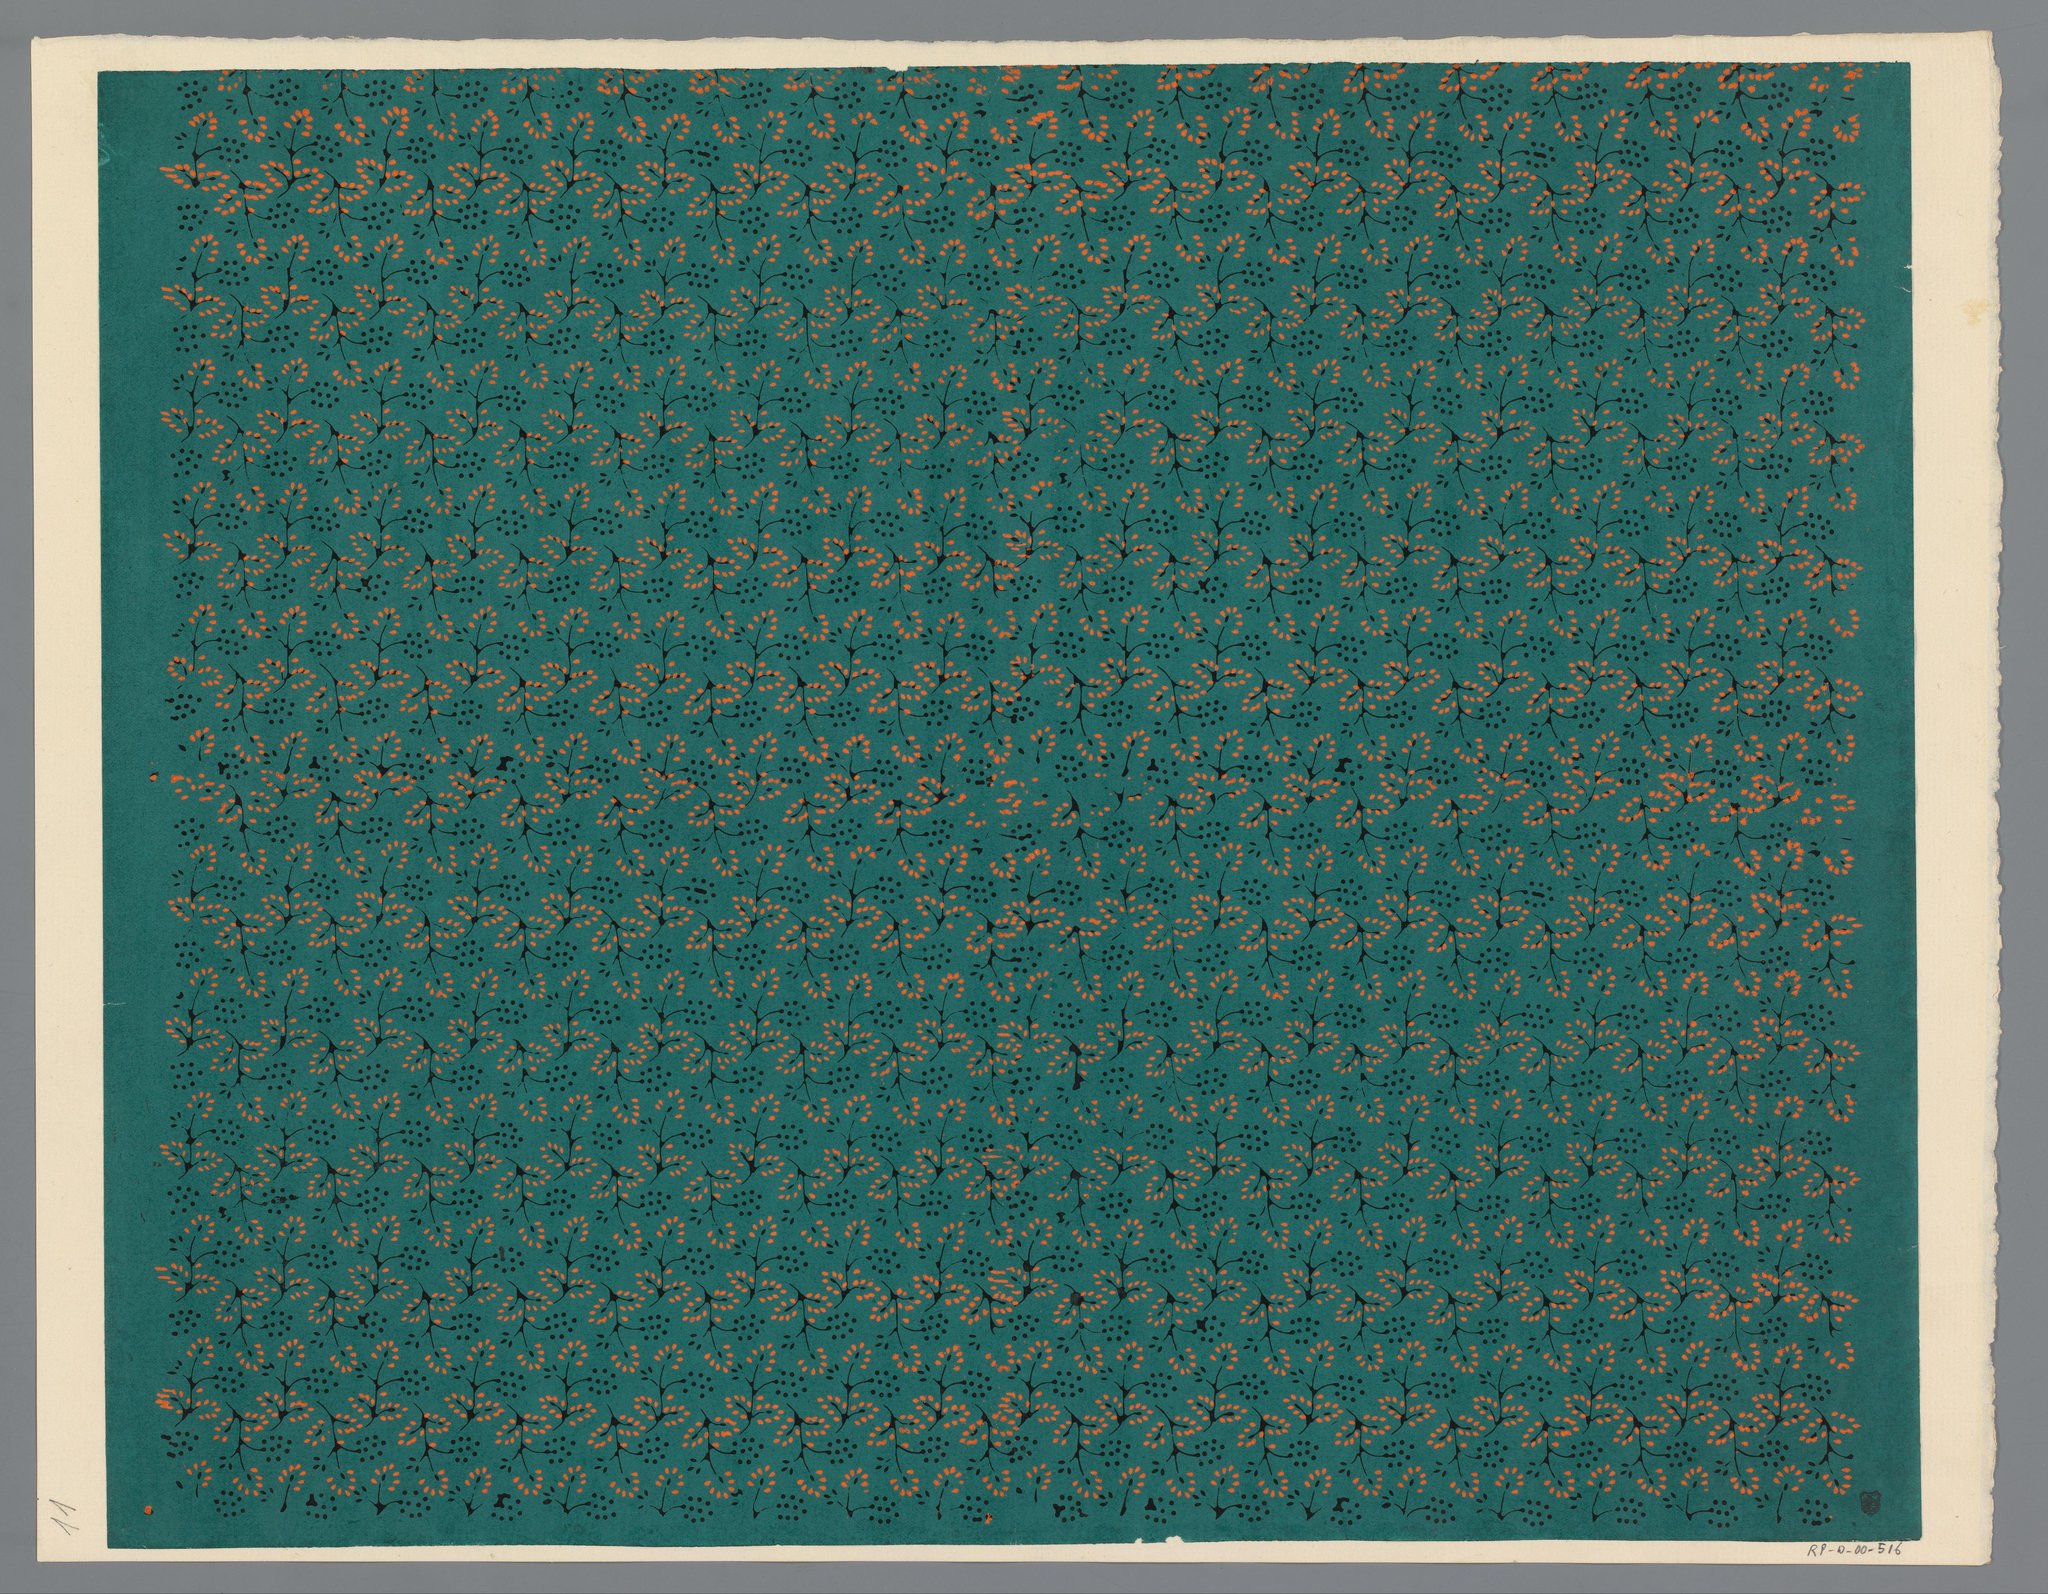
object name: printed paper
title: Blad met strooipatroon van bladmotief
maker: Anonymous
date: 1800-1900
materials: paint, paper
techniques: printing block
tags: ornament derived from plant forms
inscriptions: collector's mark: Lugt 2760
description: Blad met strooipatroon van motief van bladertak met vruchten.